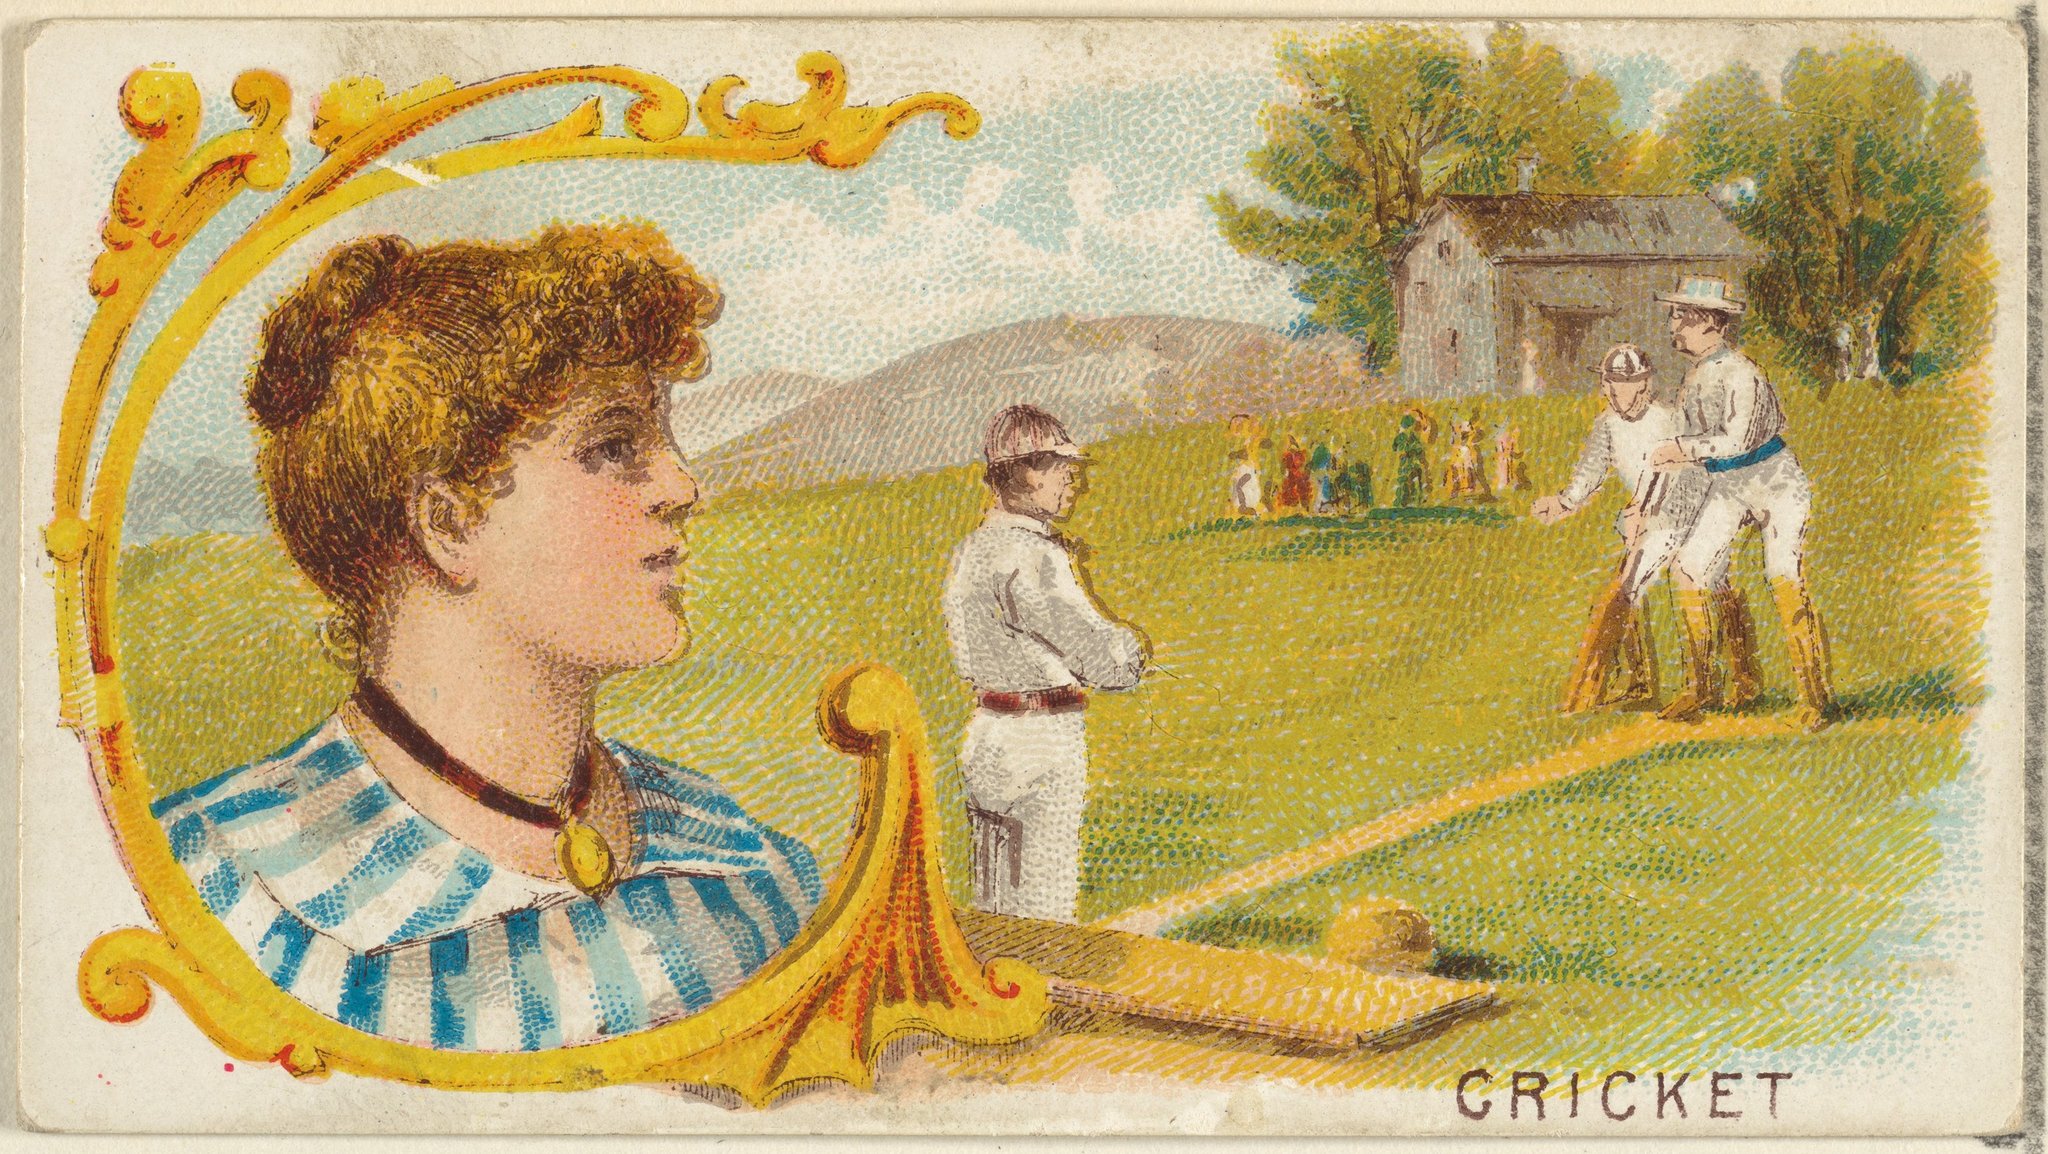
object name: print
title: Cricket, from the Games and Sports series (N165) for Old Judge Cigarettes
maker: goodwin & company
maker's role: publisher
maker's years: 1850-1950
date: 1889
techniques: color lithograph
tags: men,women,sports